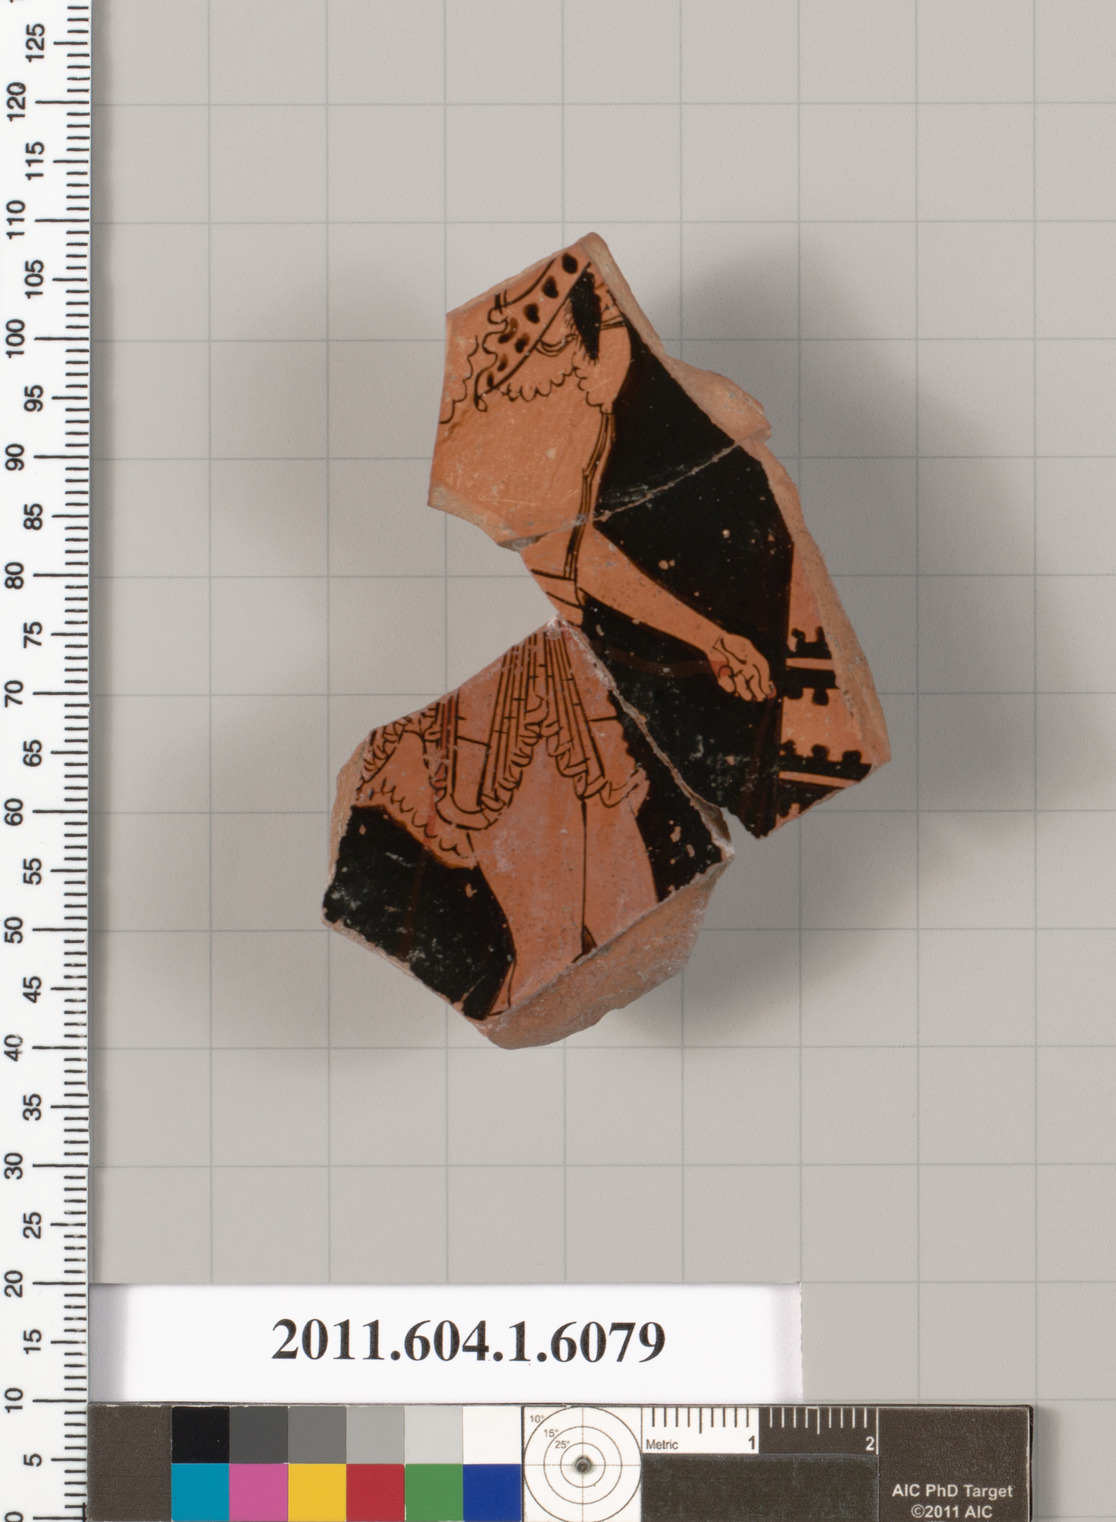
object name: kylix fragment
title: Terracotta fragment of a kylix (drinking cup)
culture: greek, attic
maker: apollodoros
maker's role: artist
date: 500-490 BCE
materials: terracotta